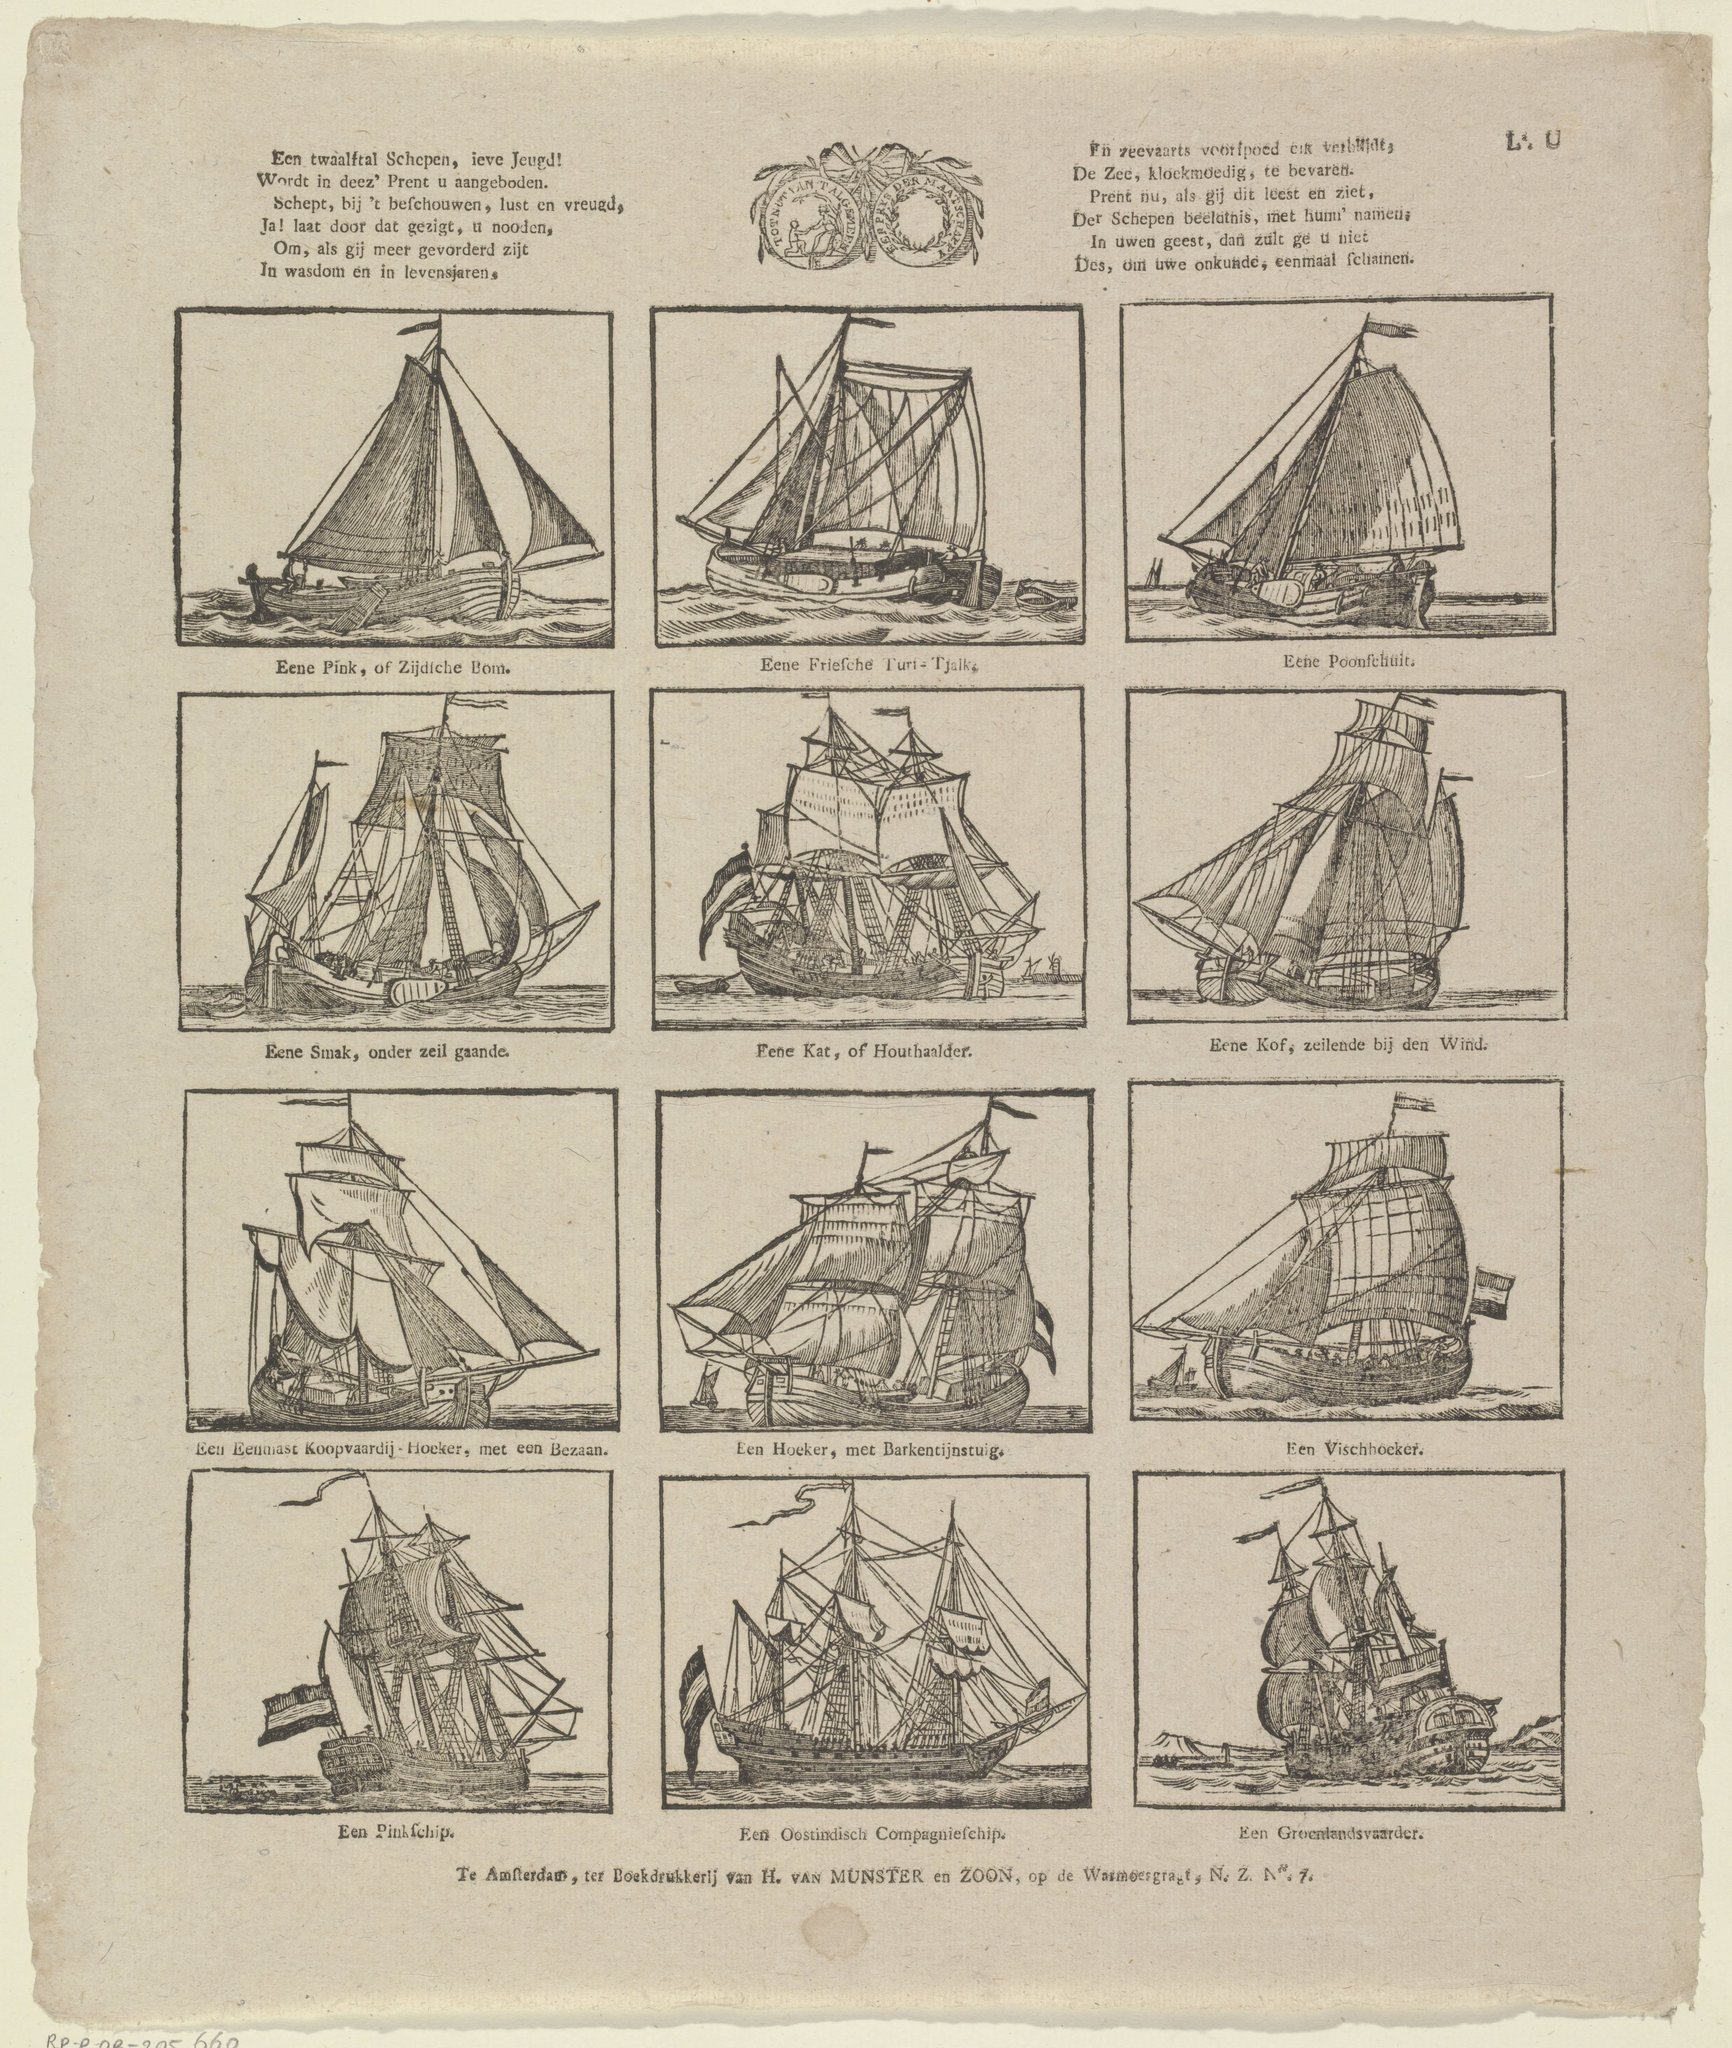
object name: popular print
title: Een twaalftal schepen, lieve Jeugd! / Wordt in deez' prent u aangeboden [(...)]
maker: Anonymous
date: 1811-1829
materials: paper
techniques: letterpress printing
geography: amsterdam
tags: traffic on the water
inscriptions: collector's mark: Lugt 2760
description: Blad met 12 voorstellingen van Hollandse schepen voor op zee en voor de binnenvaart. Midden boven het zegel van de Maatschappij tot Nut van 't Algemeen. Onder elke afbeelding de naam van het scheepstype. Genummerd rechtsboven: L.U.